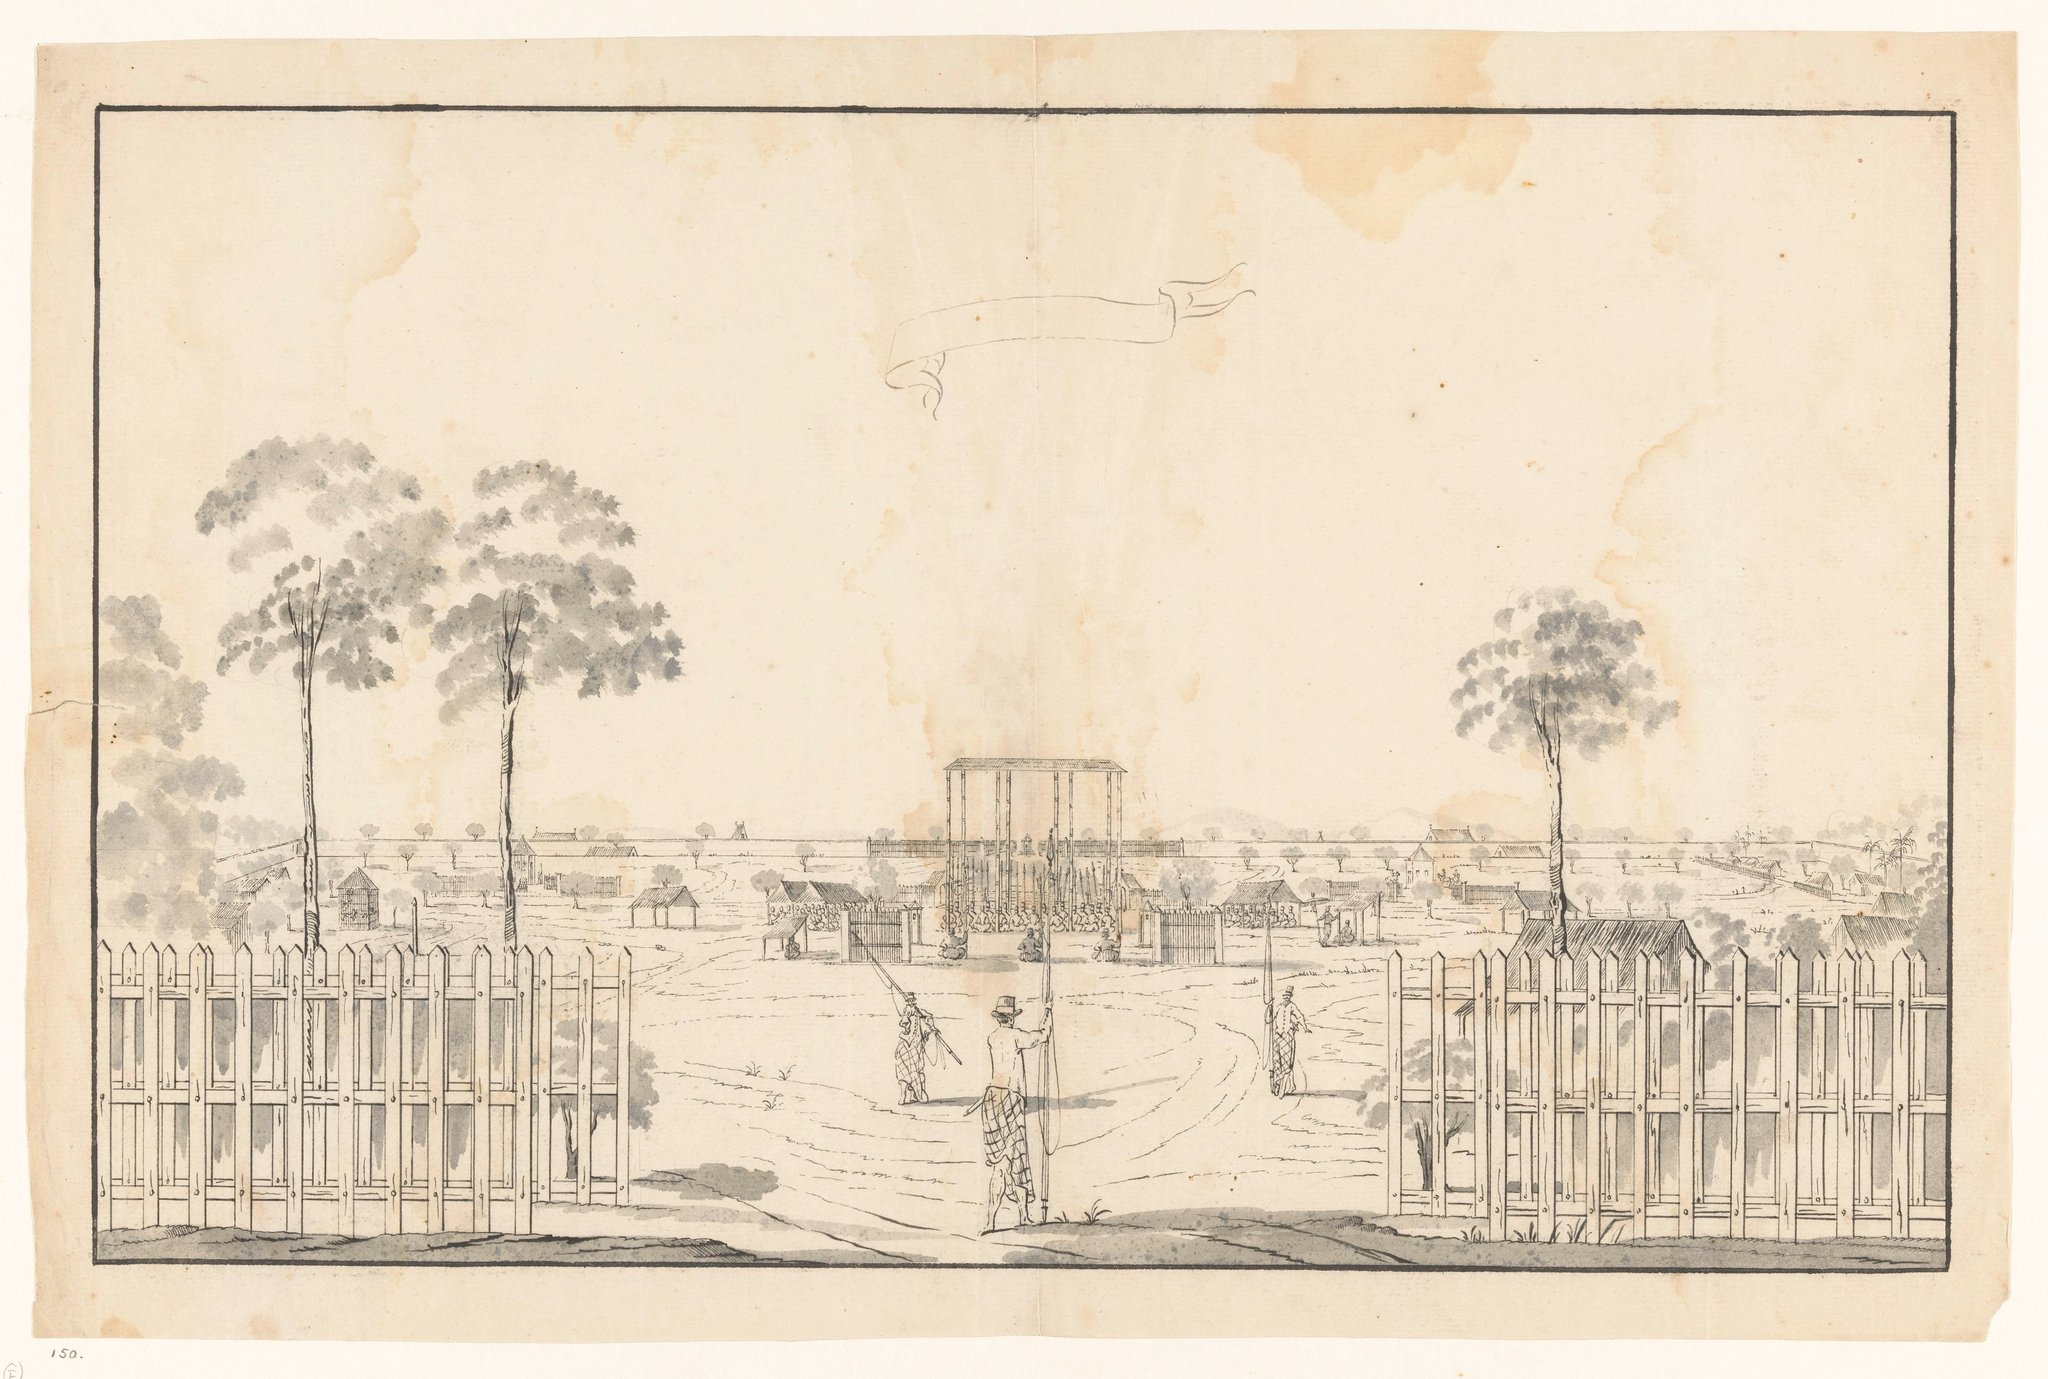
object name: drawing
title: De kraton te Djocja (Mataram)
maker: jan brandes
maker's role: draughtsman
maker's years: 1743-1808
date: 1779-1785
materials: paper, pencil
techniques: brush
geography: jogjakarta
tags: palace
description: De kraton te Yogjakarta. Groot terrein met hek omgeven, voor wachters in sarong en met kris en lans en hoge hoed. Midden achter ceremonie en paalgebouwen.